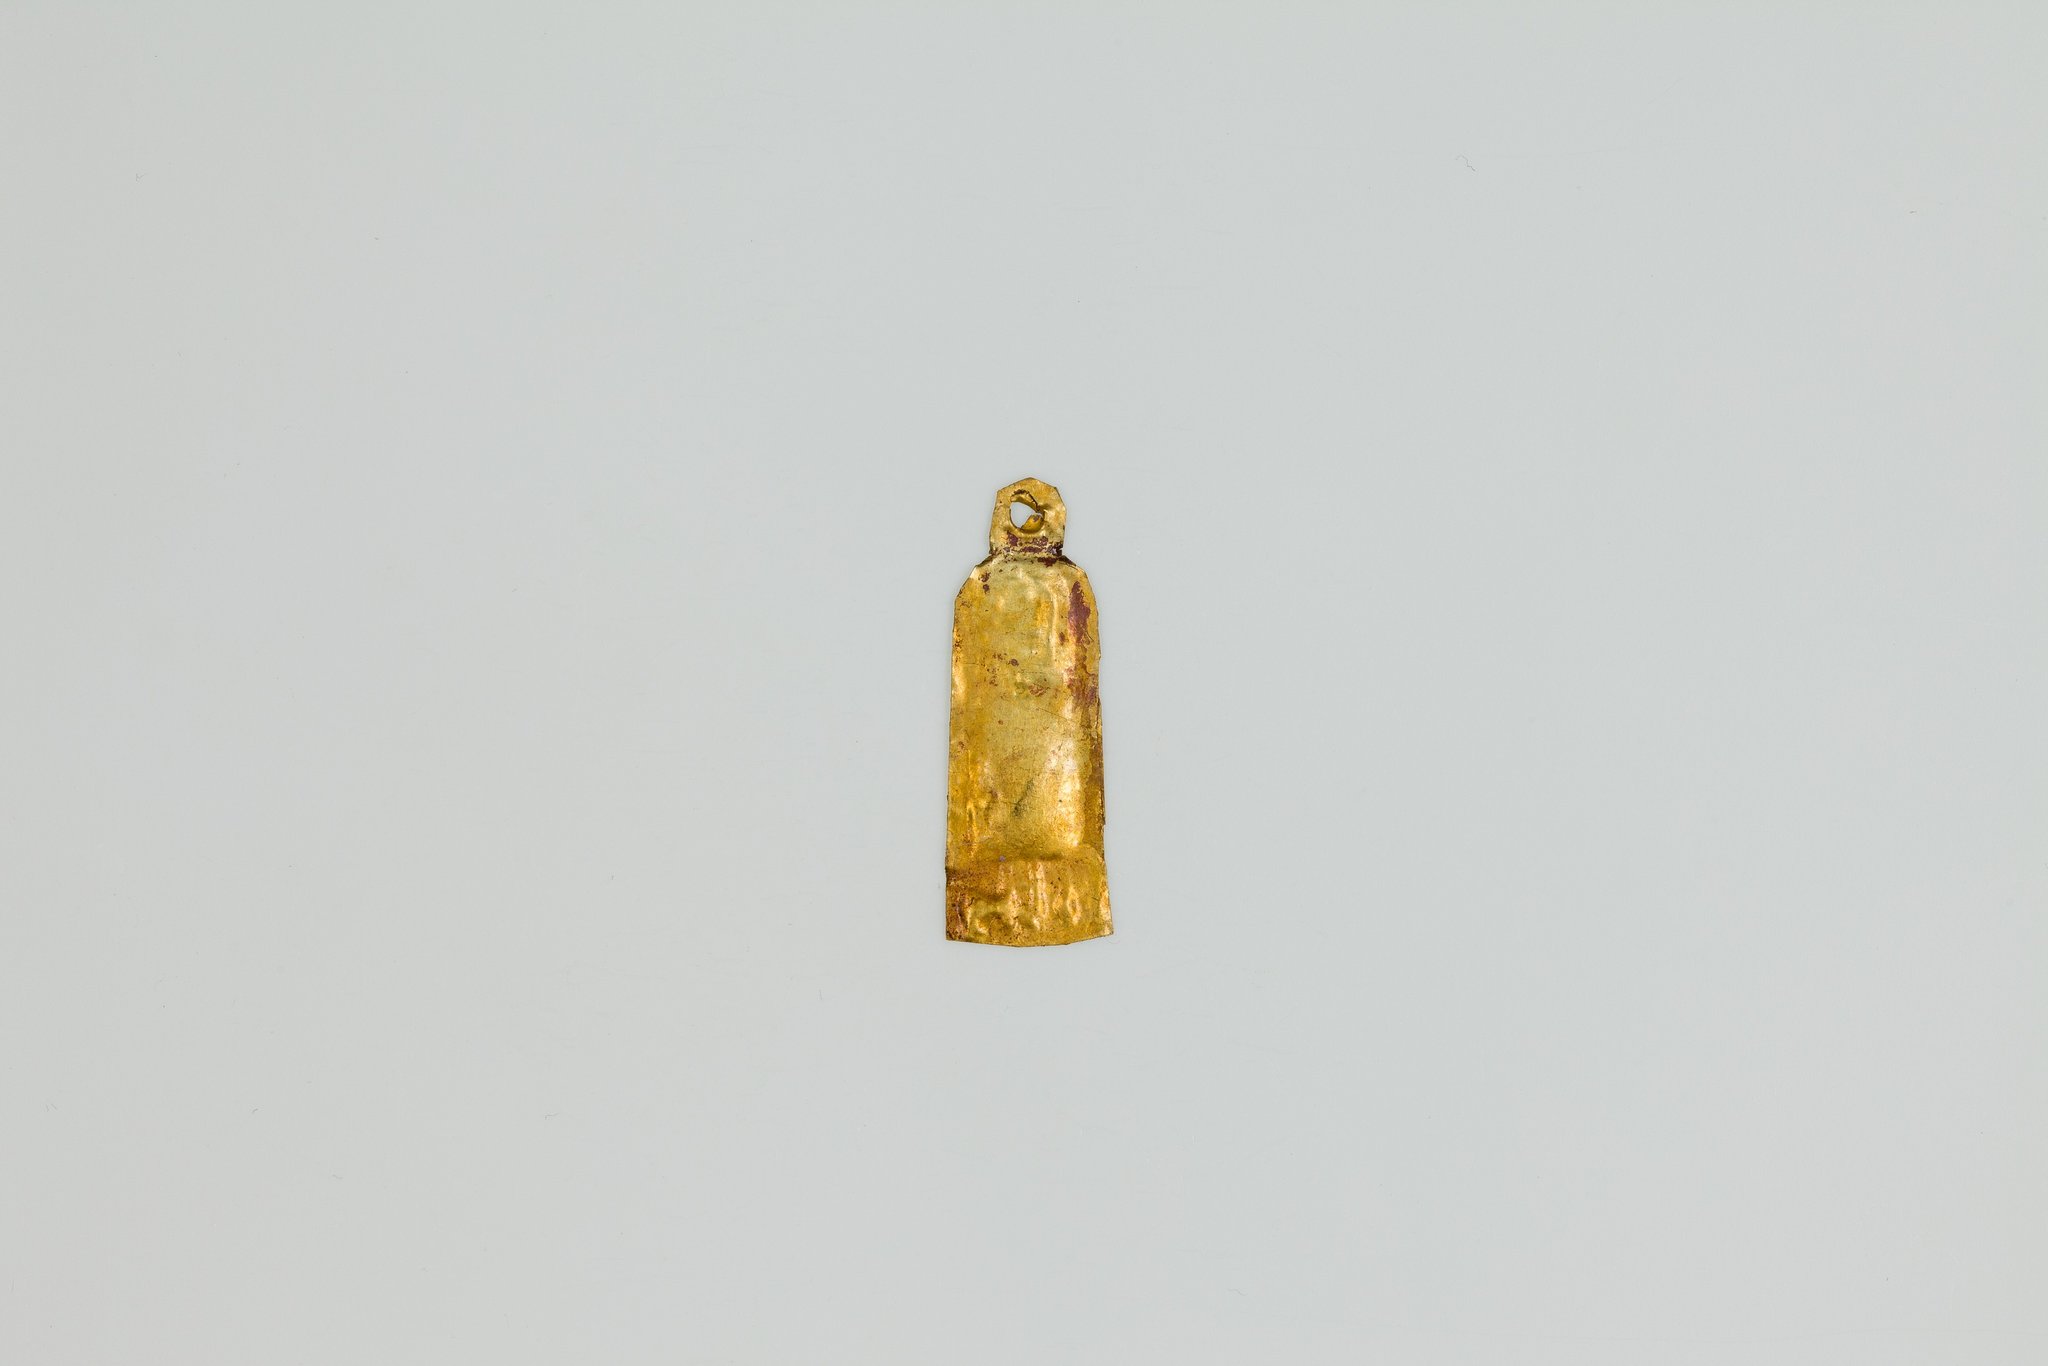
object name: amulet, aper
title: Aper amulet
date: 664-380 BCE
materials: gold